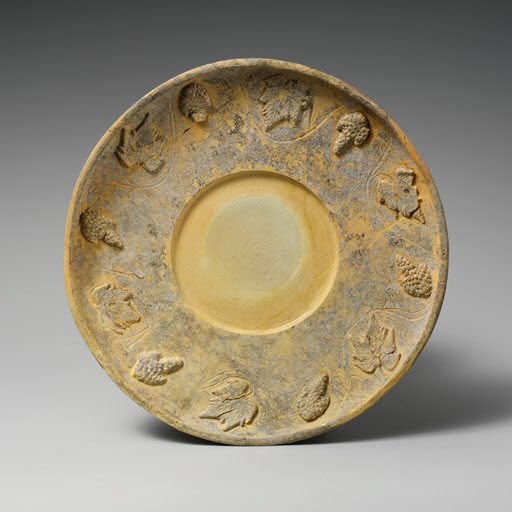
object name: phiale, silvered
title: Terracotta phiale (libation bowl)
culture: etruscan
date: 250-200 BCE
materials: terracotta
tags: grapes,leaves